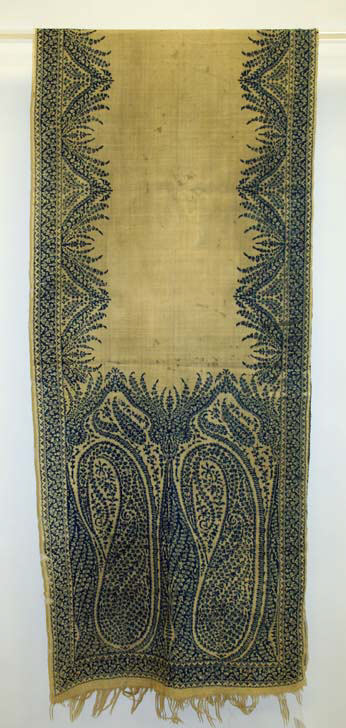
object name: scarf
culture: french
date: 1812-1820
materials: wool